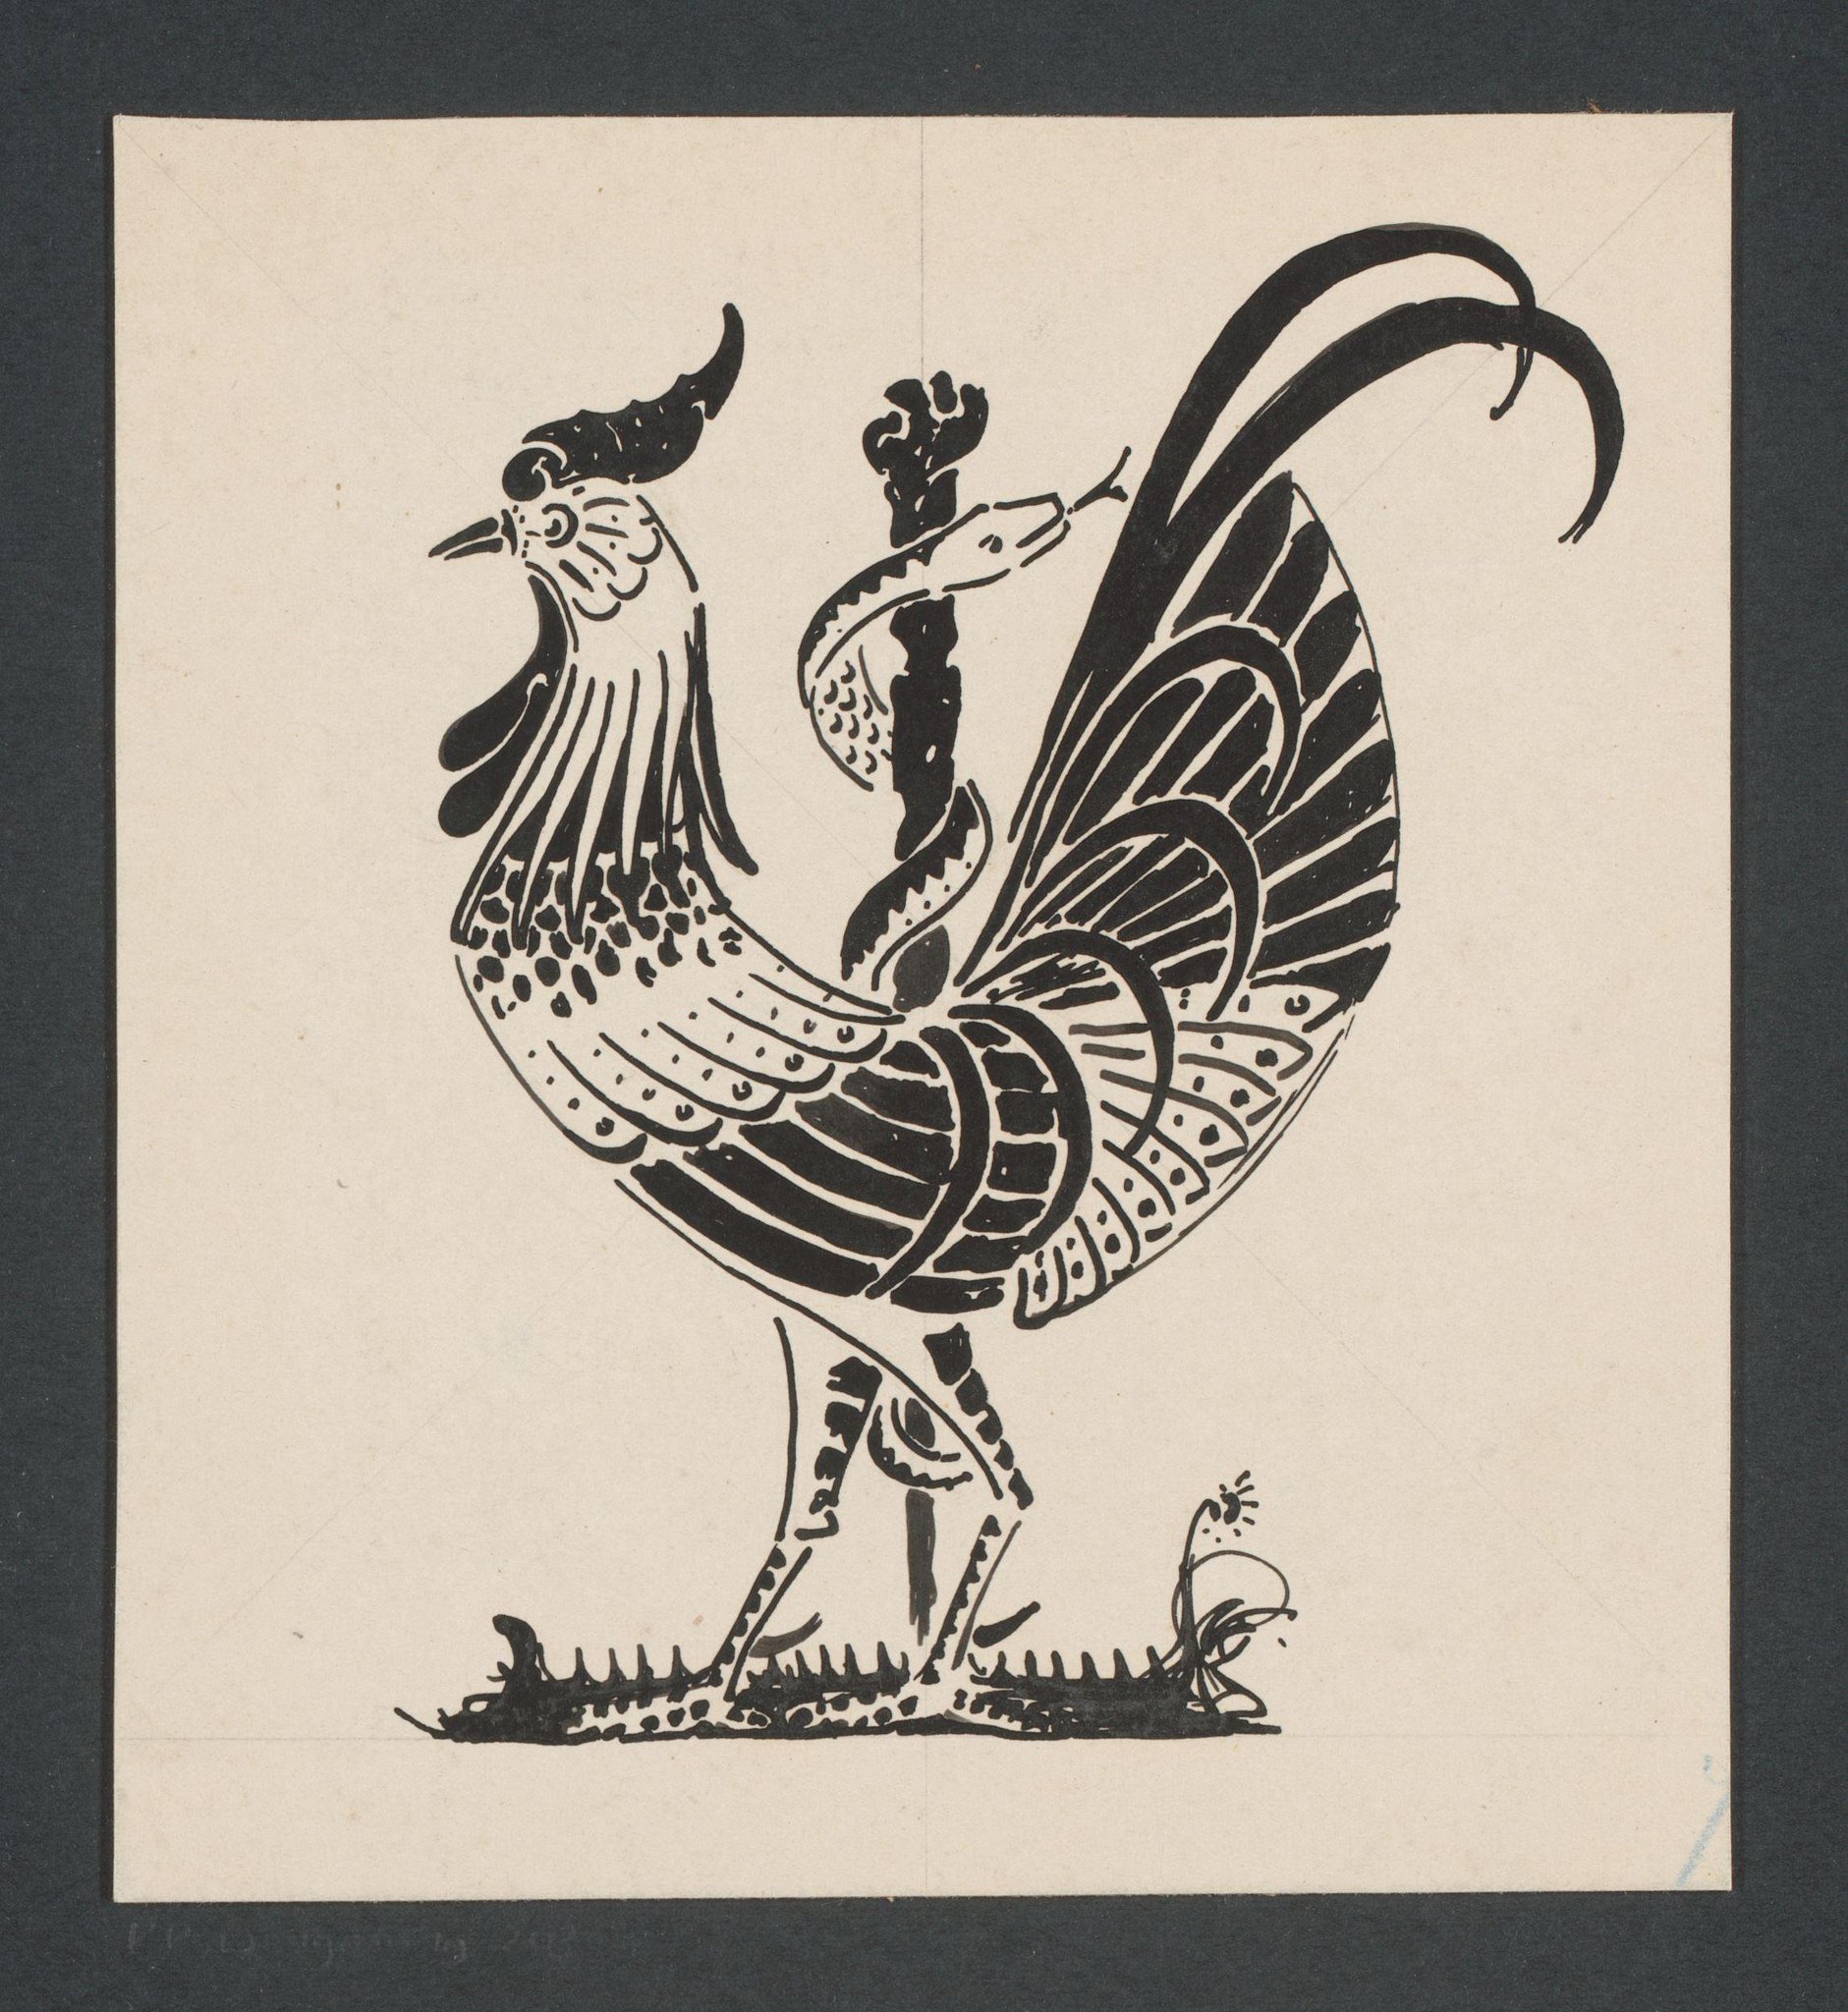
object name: drawing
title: Haan met esculaap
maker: reinier willem petrus de vries (1874-1953)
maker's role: draughtsman, print maker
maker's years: 1874-1953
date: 1884-1952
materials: ink, paper, pencil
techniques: brush, pen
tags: attributes of aesculapius: cock, aesculapian sign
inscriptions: collector's mark: ‘R:MVS.’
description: Symbolen van Asclepius, de Griekse god van de geneeskunde.